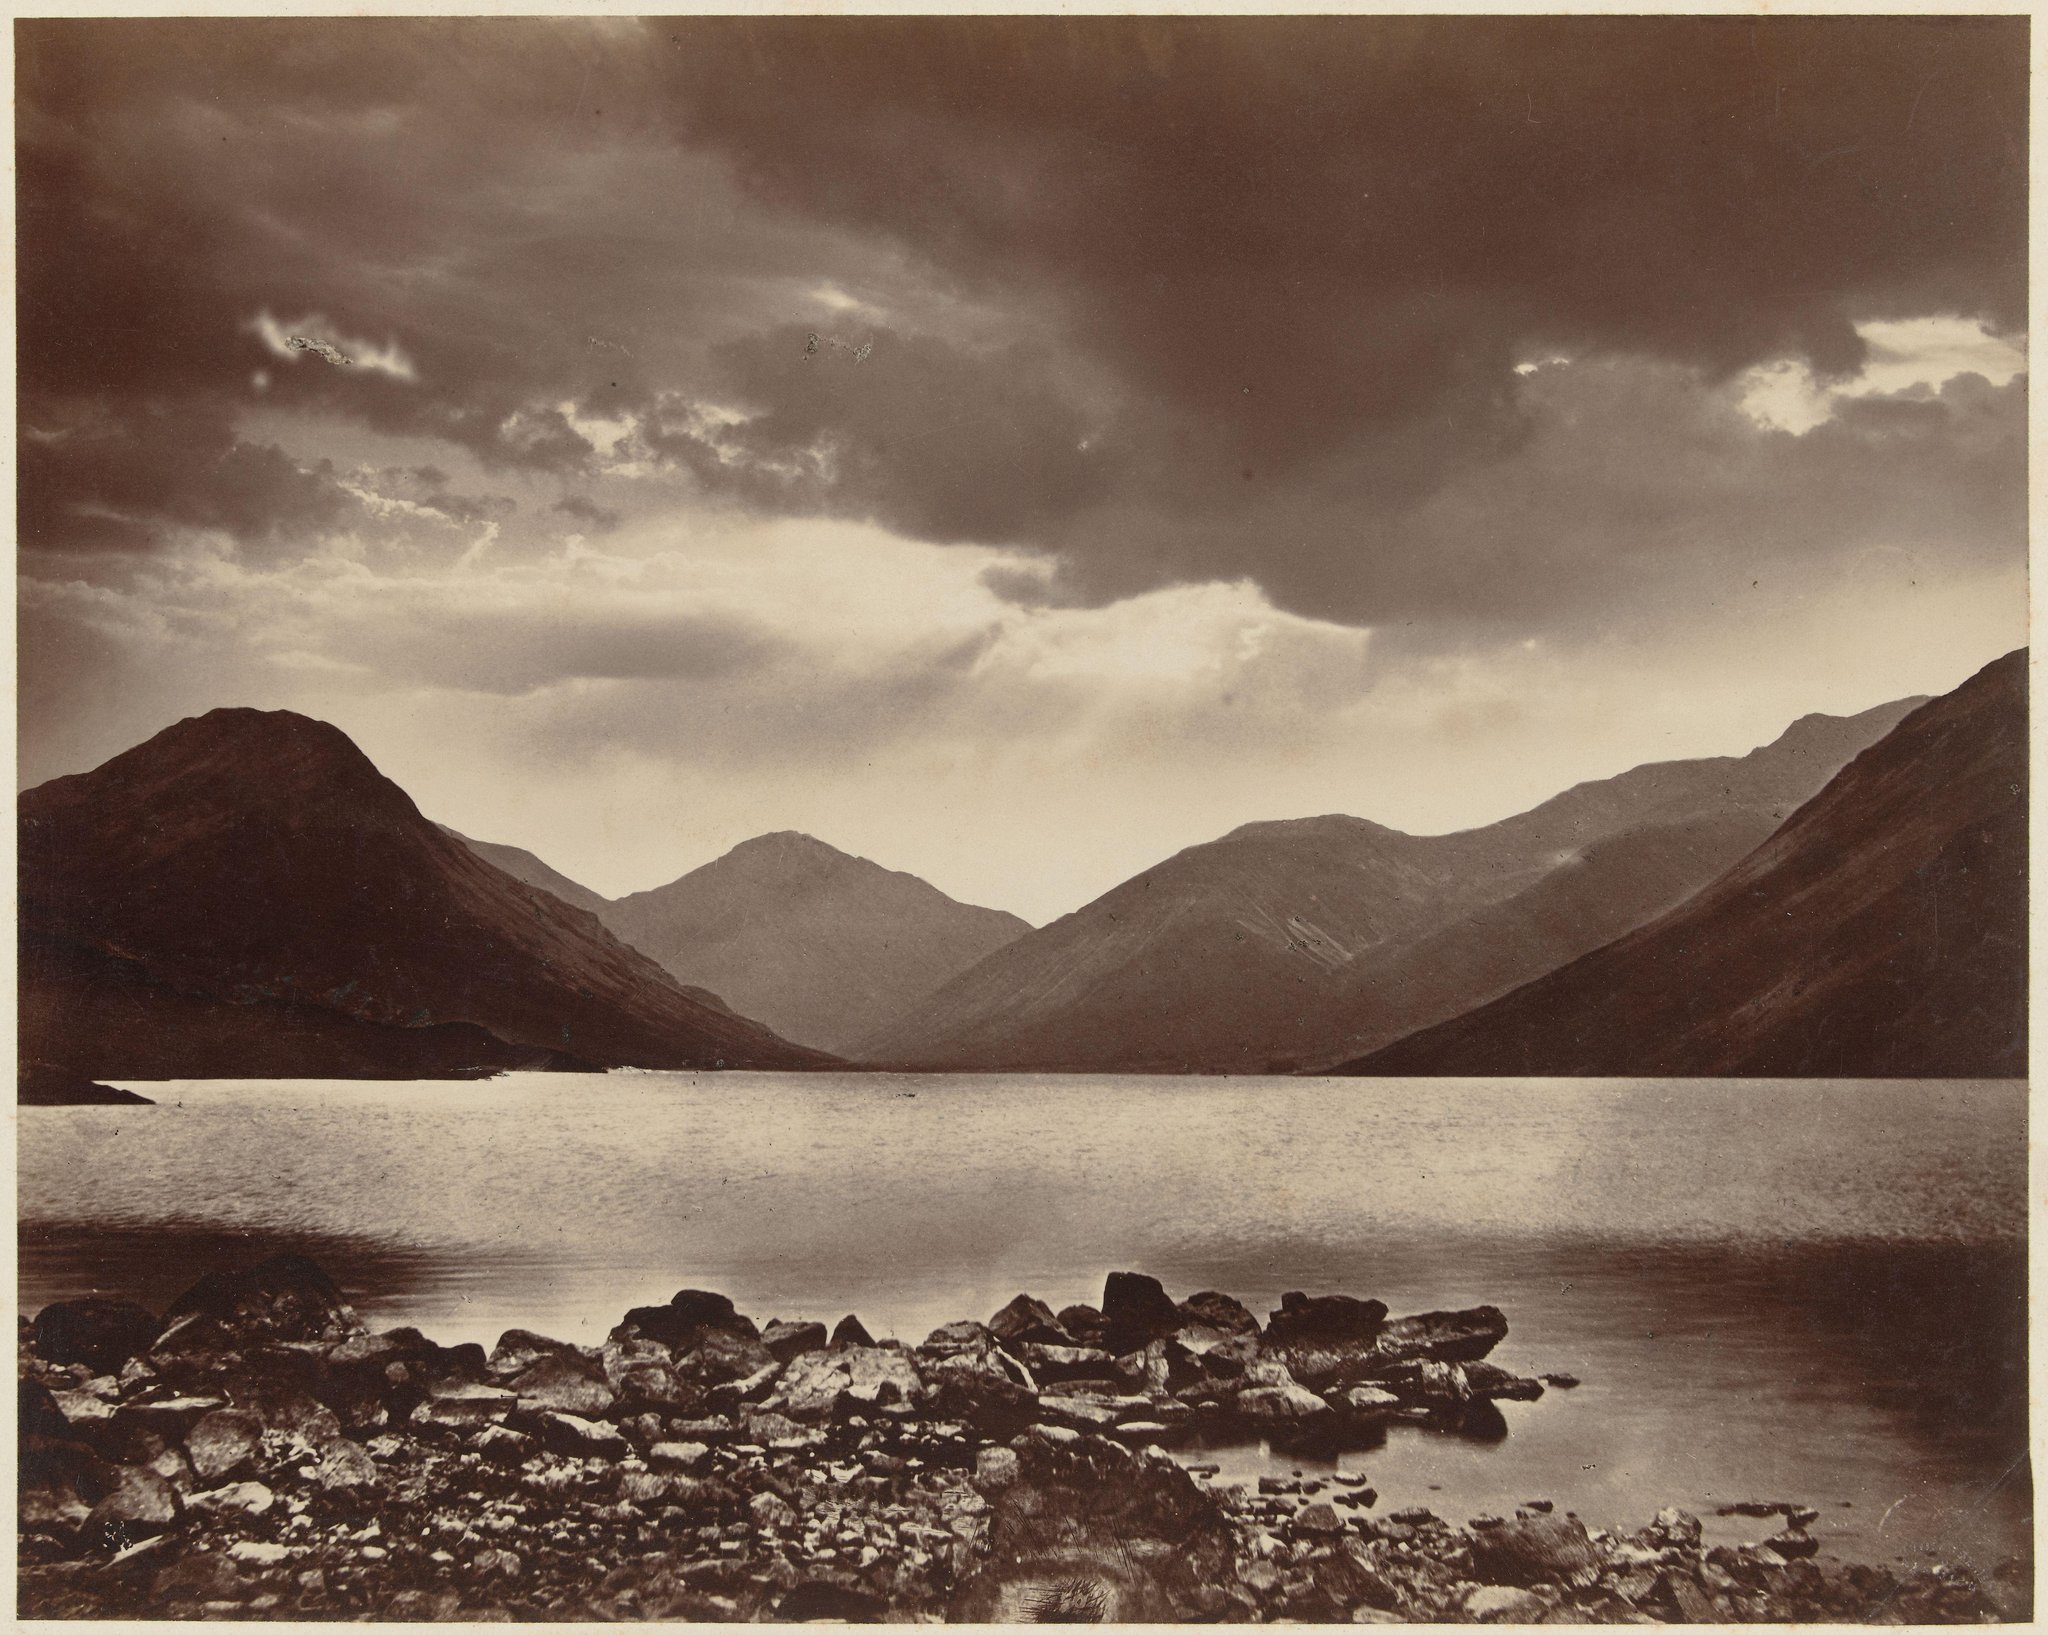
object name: photograph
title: Pettitt Series Keswick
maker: alfred pettitt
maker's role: fotograaf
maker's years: 1820-1880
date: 1858-1880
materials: cardboard, paper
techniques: albumen print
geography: cumbria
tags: lake